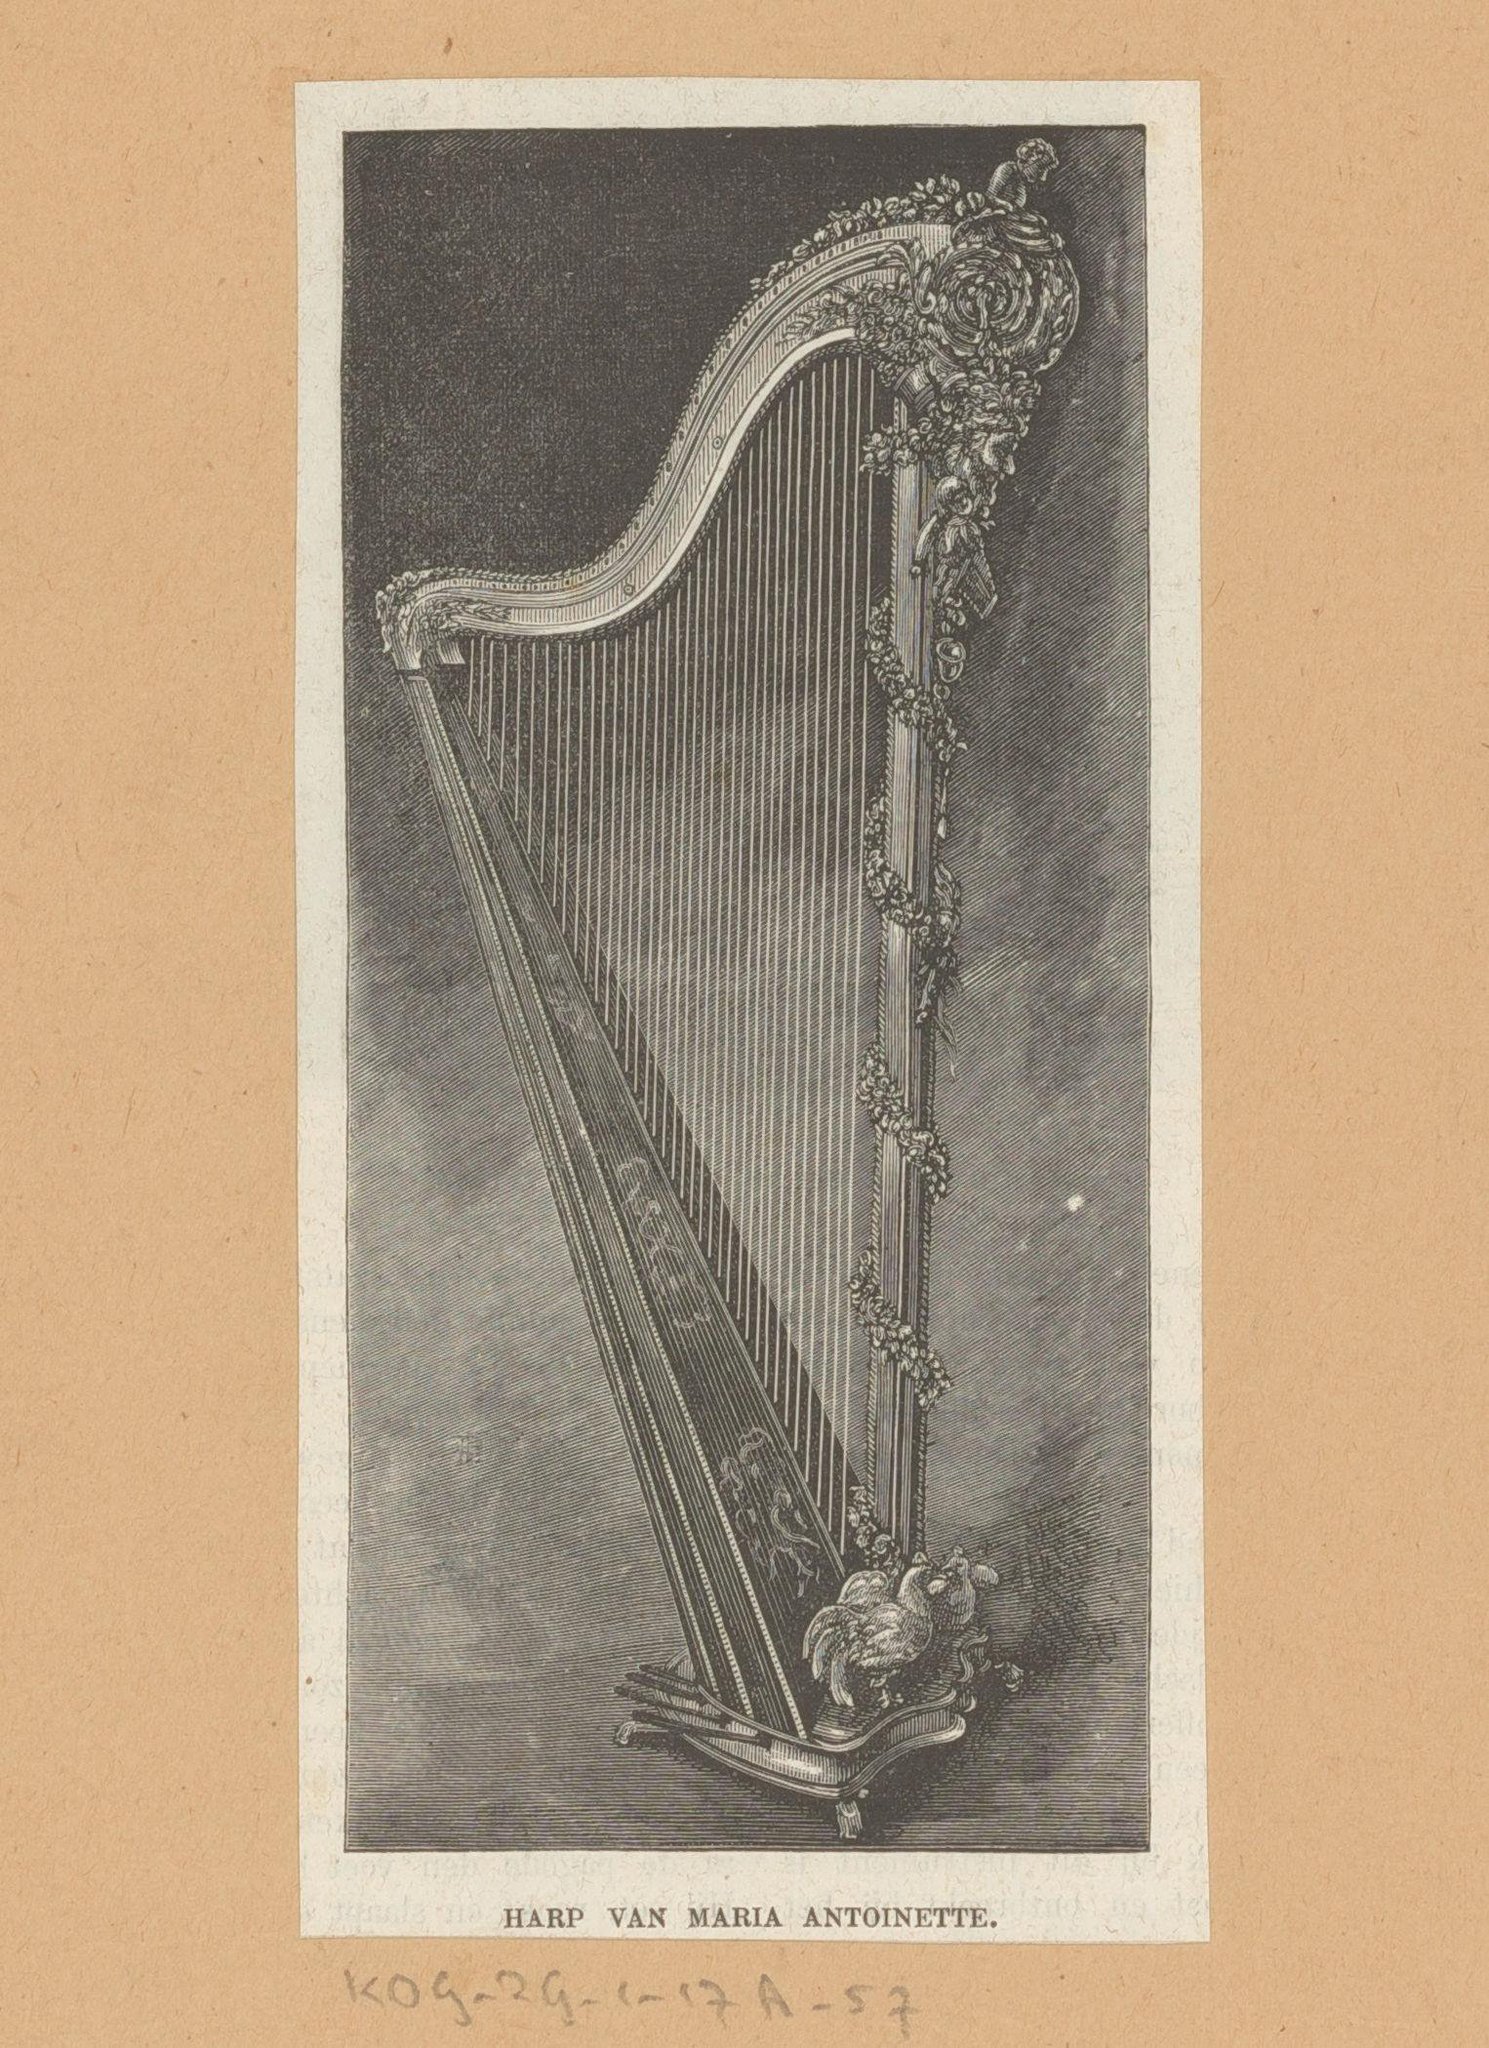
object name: print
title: Harp van Maria Antoinette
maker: Anonymous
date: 1850-1899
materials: paper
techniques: engraving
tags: vienna, paris, marie antoinette, harp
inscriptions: collector's mark, collector's mark: Lugt 1641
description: Harp. Illustratie genomen uit een boek of tijdschrift. Onderwerpsrubrieken binnen de Atlas Zeden en Gewoonten: Muziek en muziekinstrumenten: Varia.